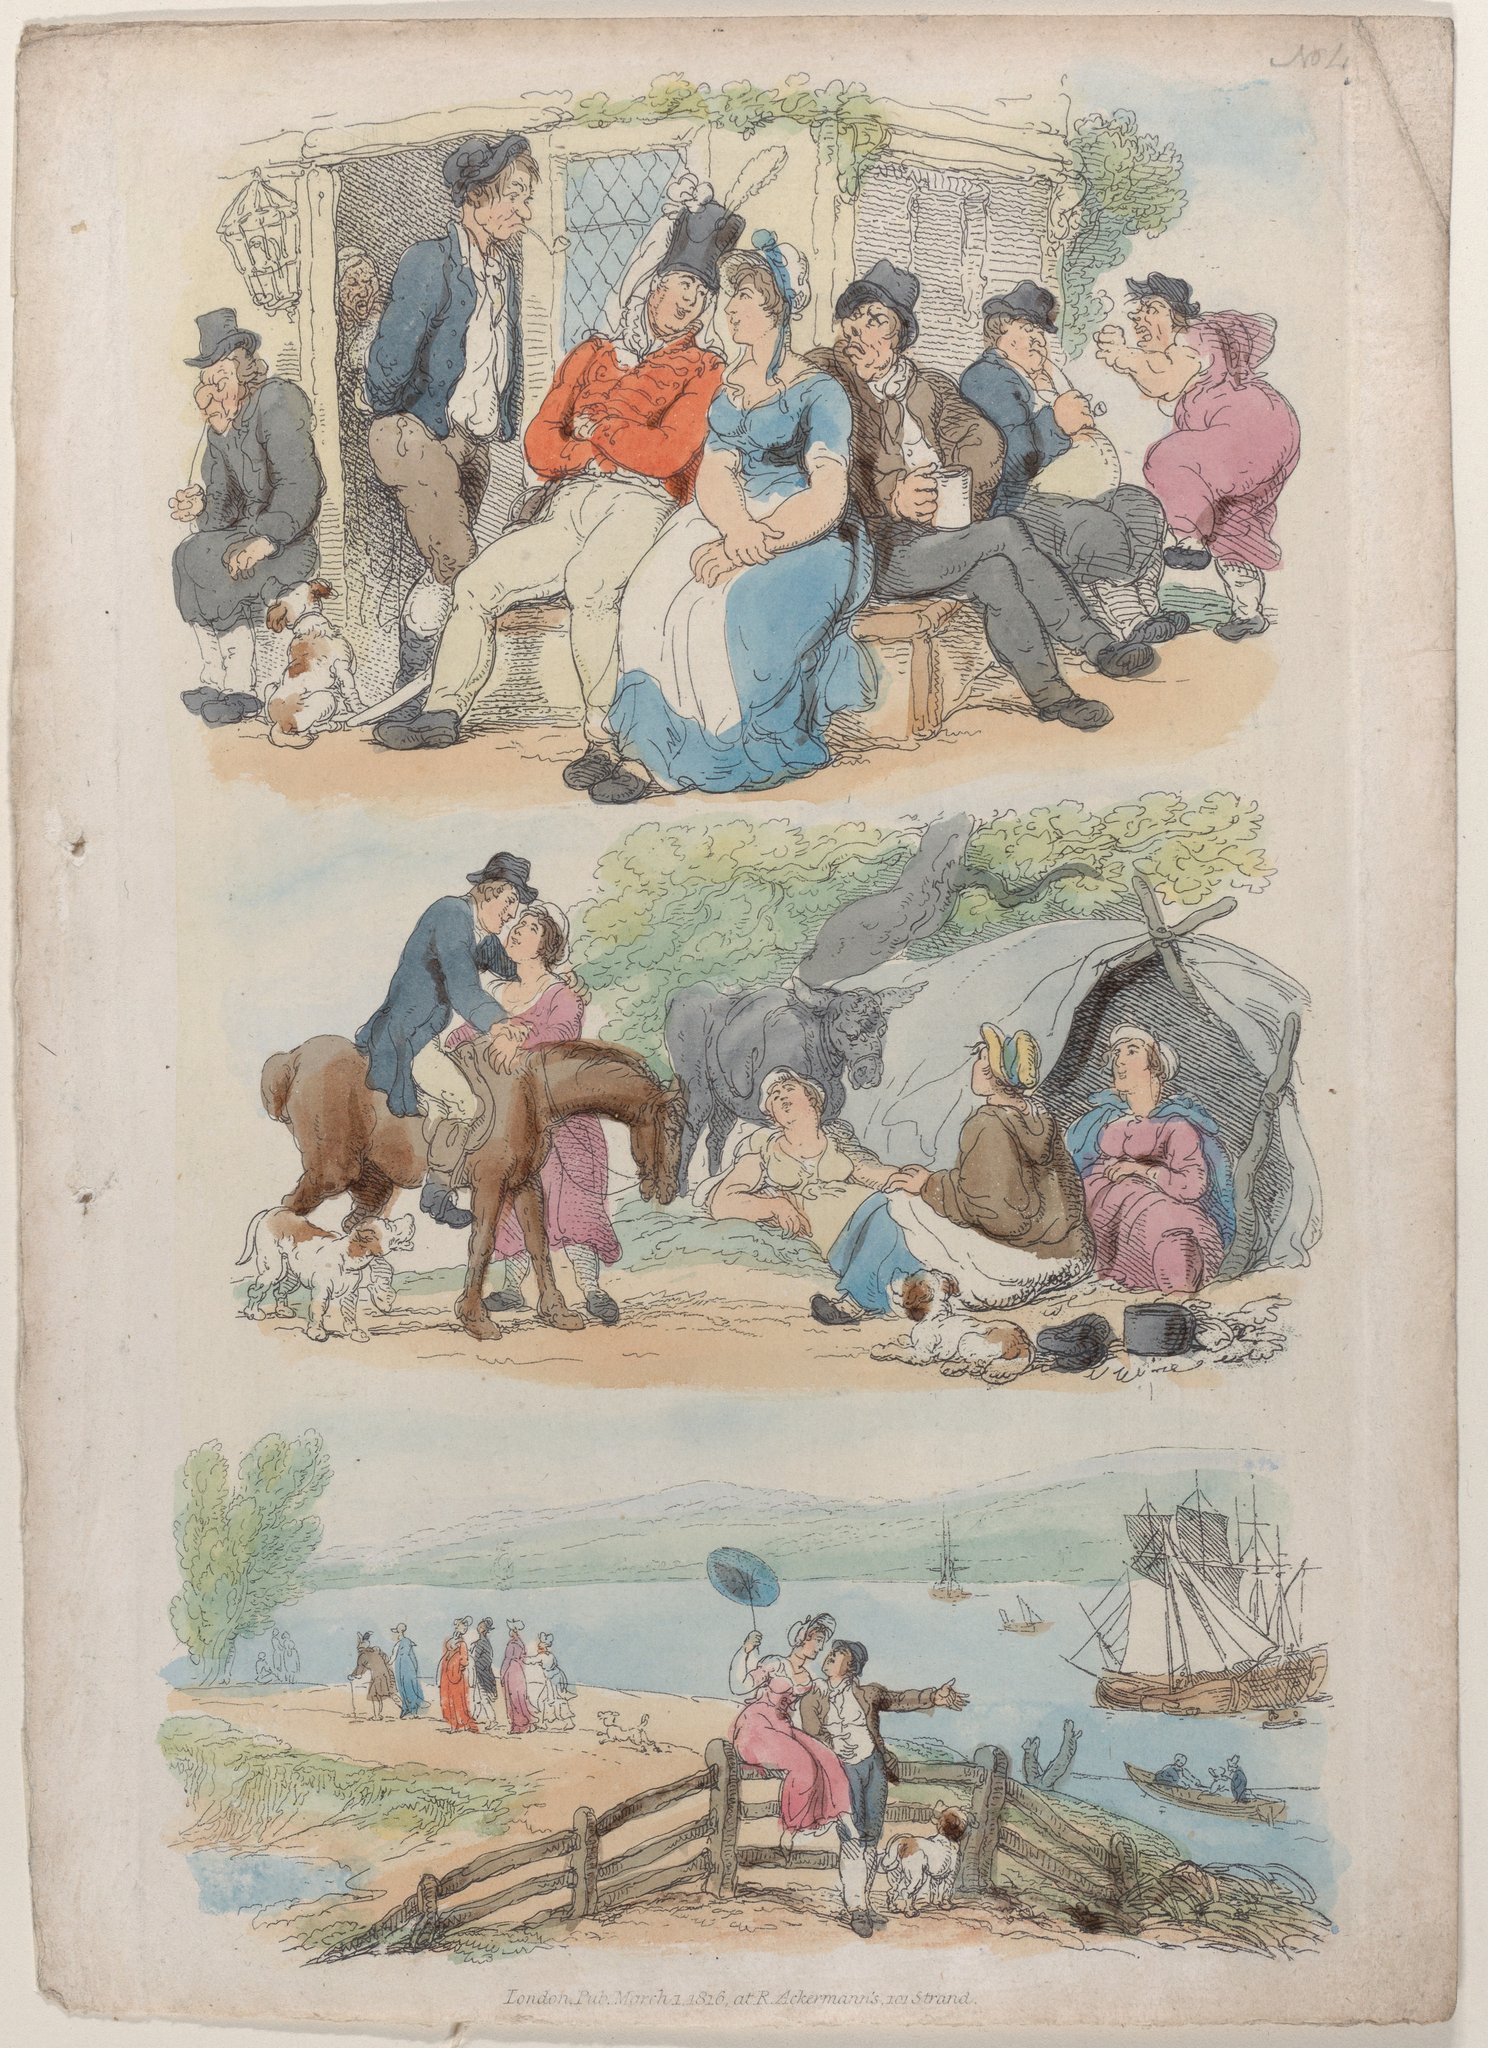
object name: print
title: Plate 4: Recruiting, from "World in Miniature"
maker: thomas rowlandson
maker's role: artist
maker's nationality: british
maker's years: 1757-1827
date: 1816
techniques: etching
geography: london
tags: men,women,dogs,horses